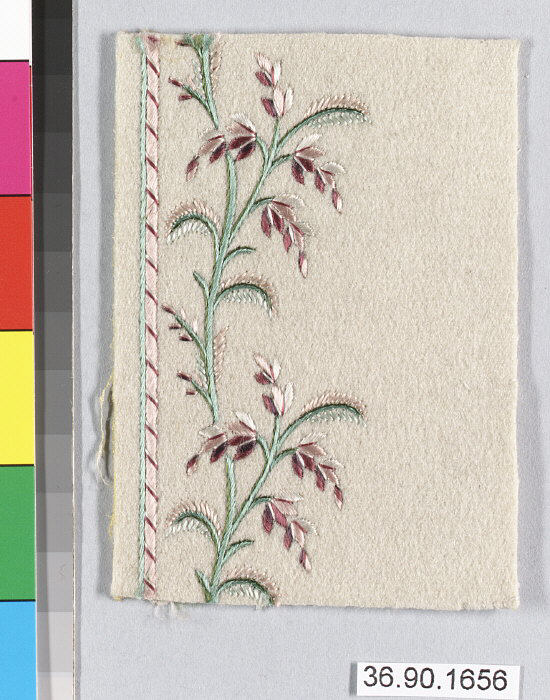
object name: sample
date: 1801-1833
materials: silk, wool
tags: flowers